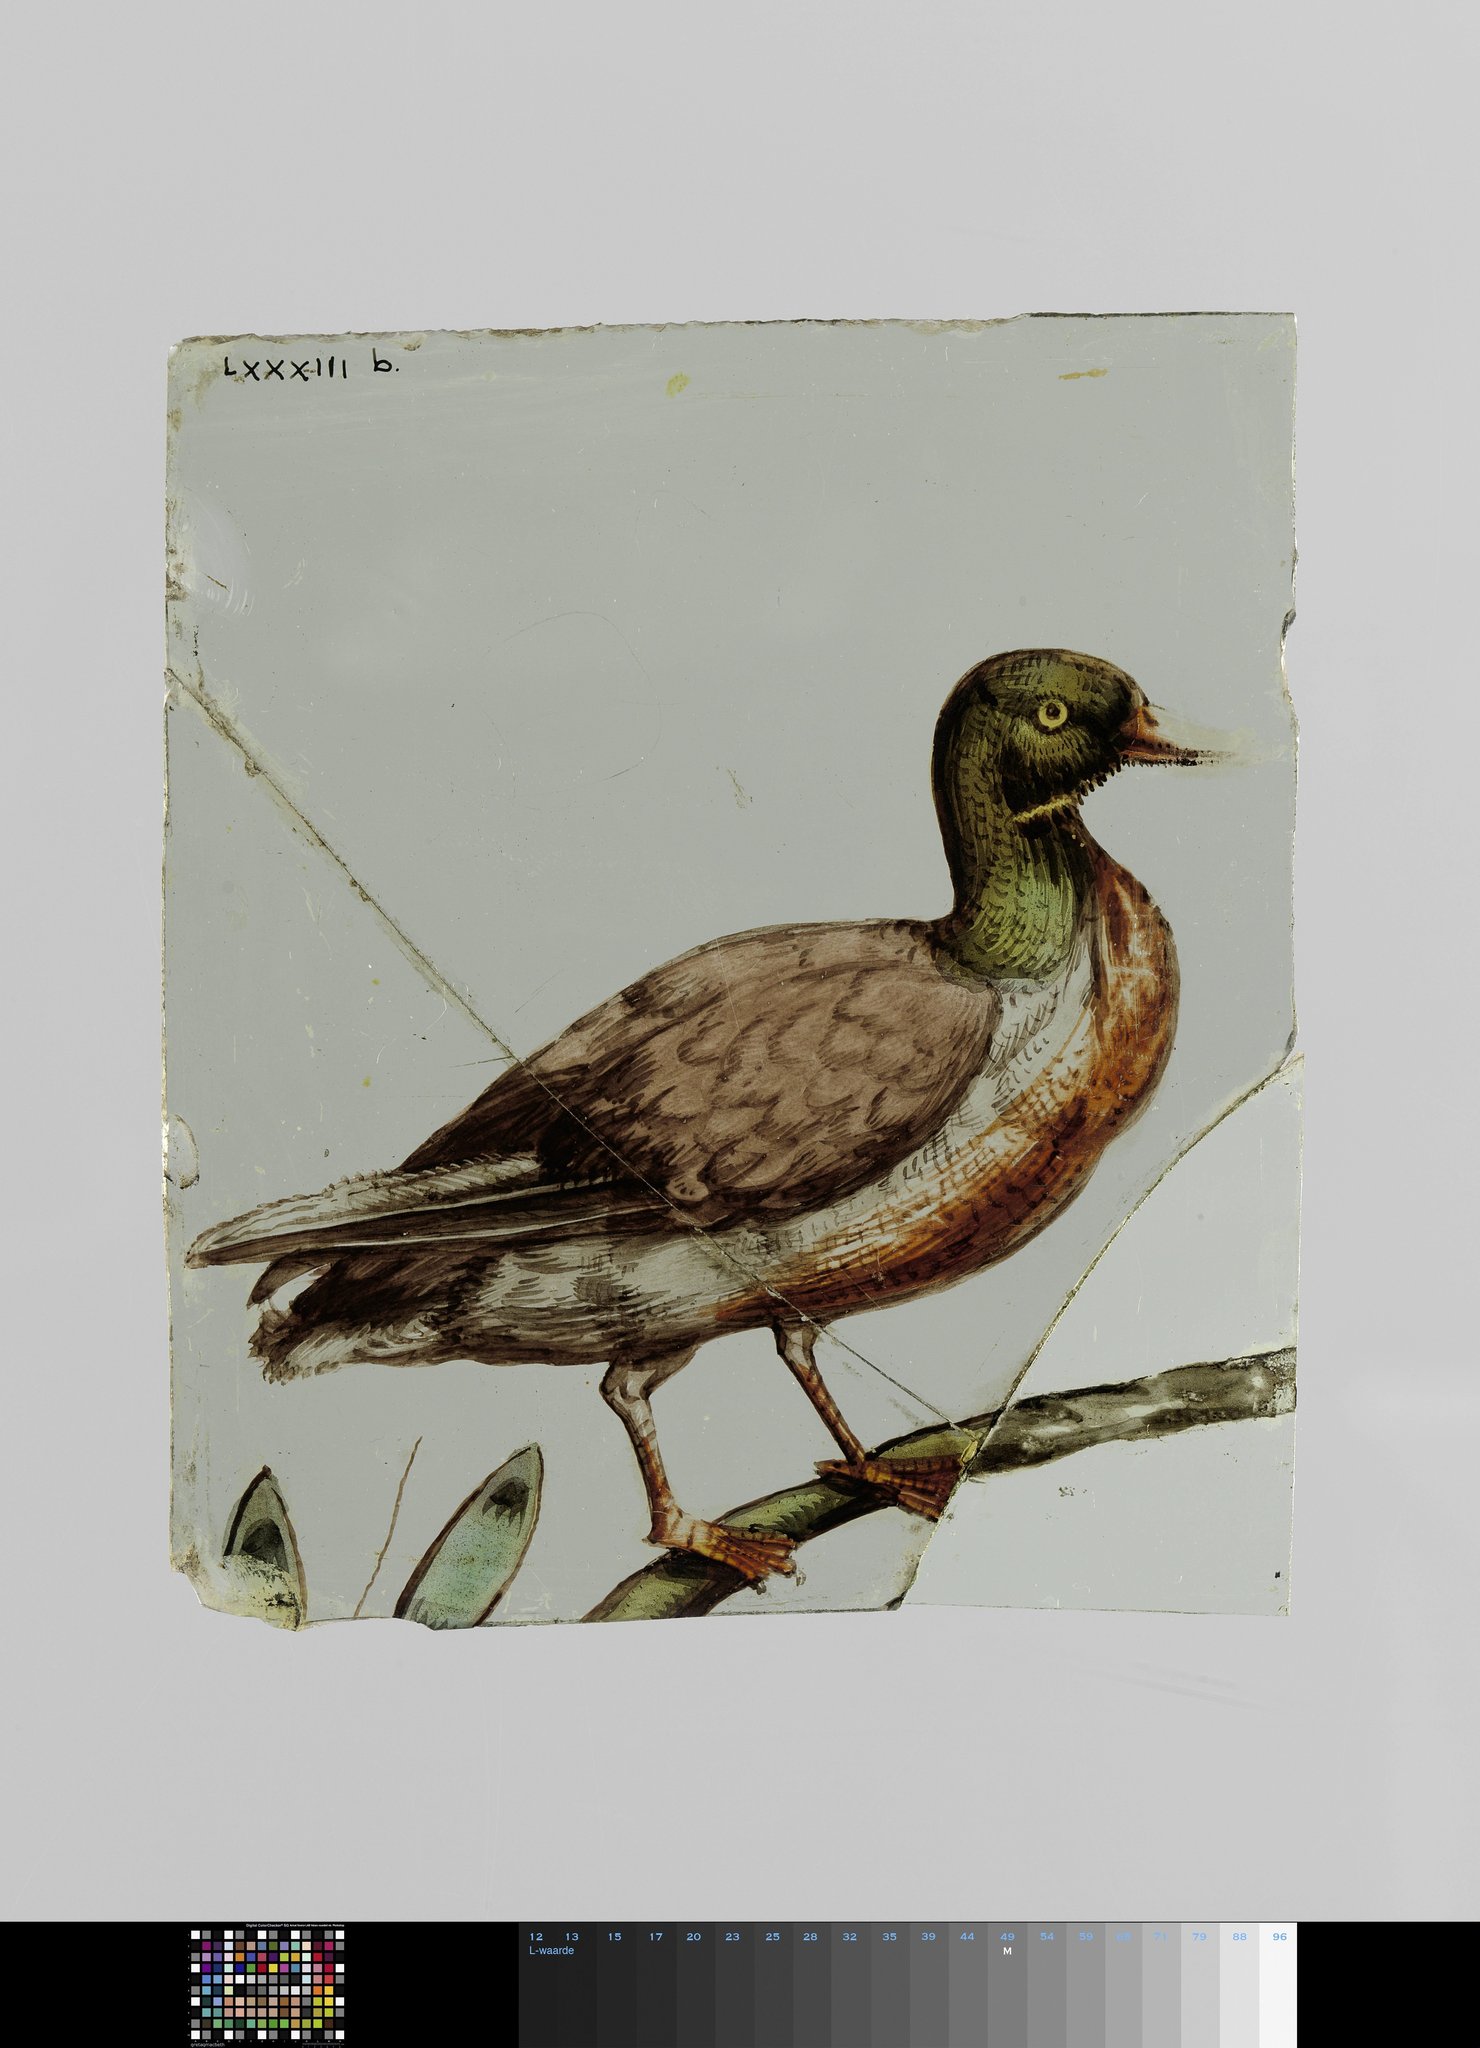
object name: light window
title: Ruit met een eend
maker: Anonymous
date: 1650-1675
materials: glass, lead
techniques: enamel painting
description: Een ruitje met emailschildering van een eend in bruin, grijs, rood en de kop in groen.